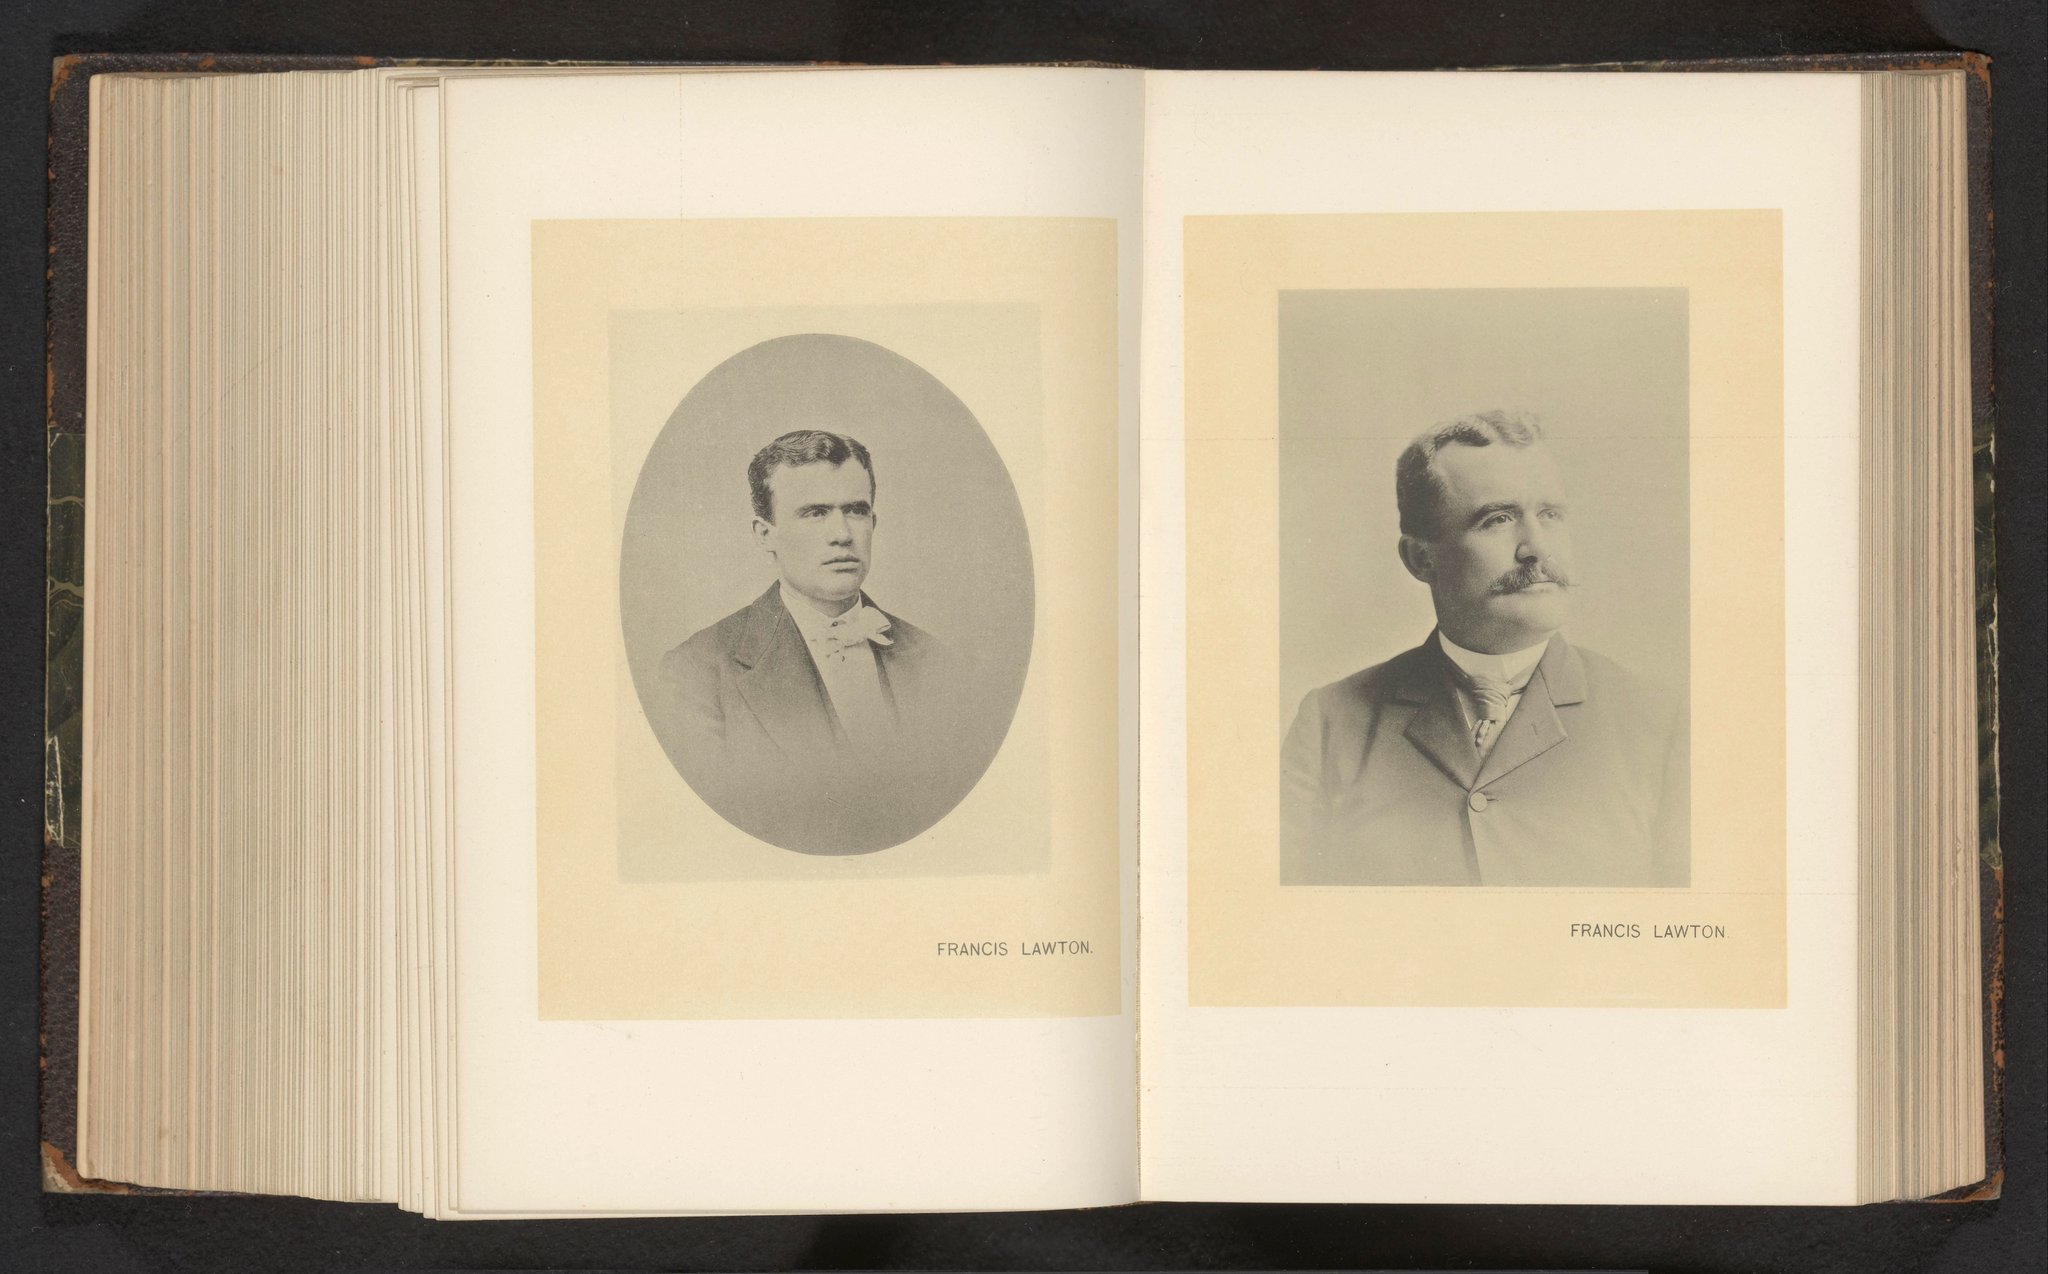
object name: page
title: Francis Lawton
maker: Anonymous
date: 1889-1894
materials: paper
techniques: photoaquatint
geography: boston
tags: adult man